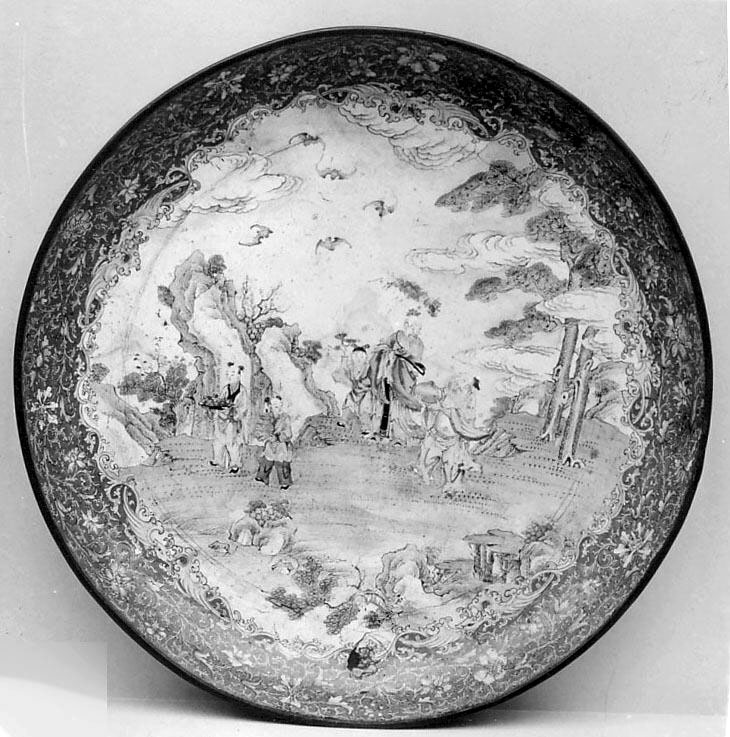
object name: dish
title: Large Dish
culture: chinese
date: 1736-1795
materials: enamel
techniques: painting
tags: human figures,birds,trees